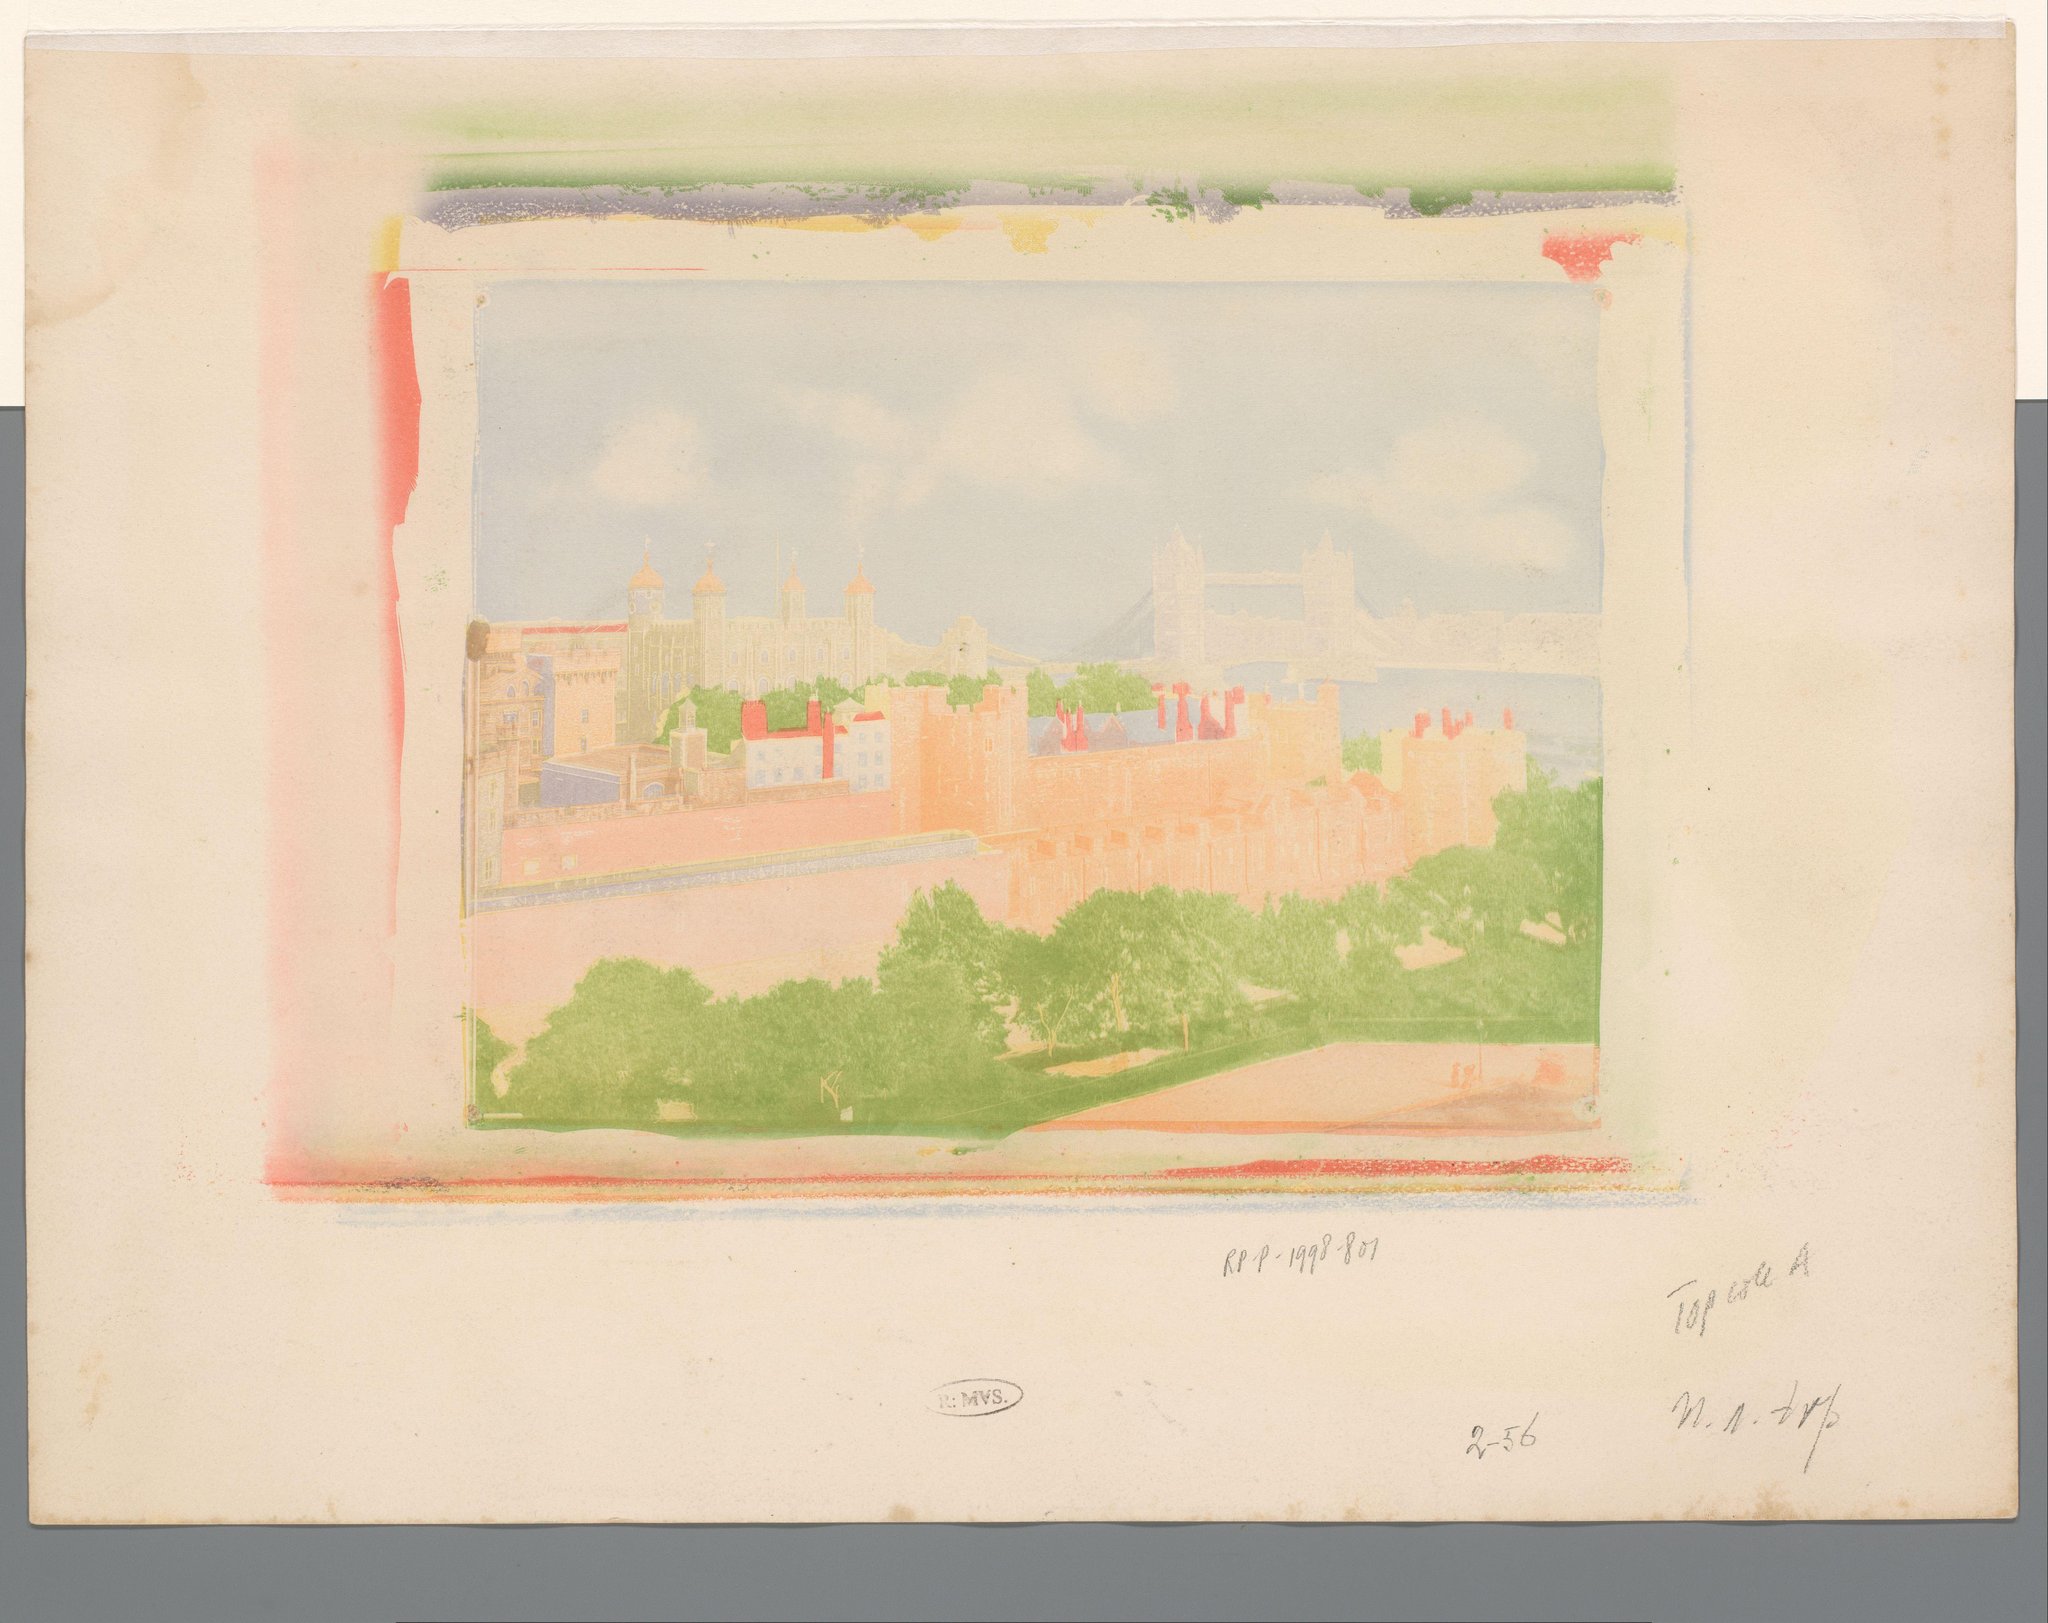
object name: print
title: Gezicht op de Tower Bridge en de Tower of London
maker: Anonymous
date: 1905-1925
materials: paper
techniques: color gum print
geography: england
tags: suspension bridge, bridge in city across river, canal, etc.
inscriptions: collector's mark: Lugt 2228